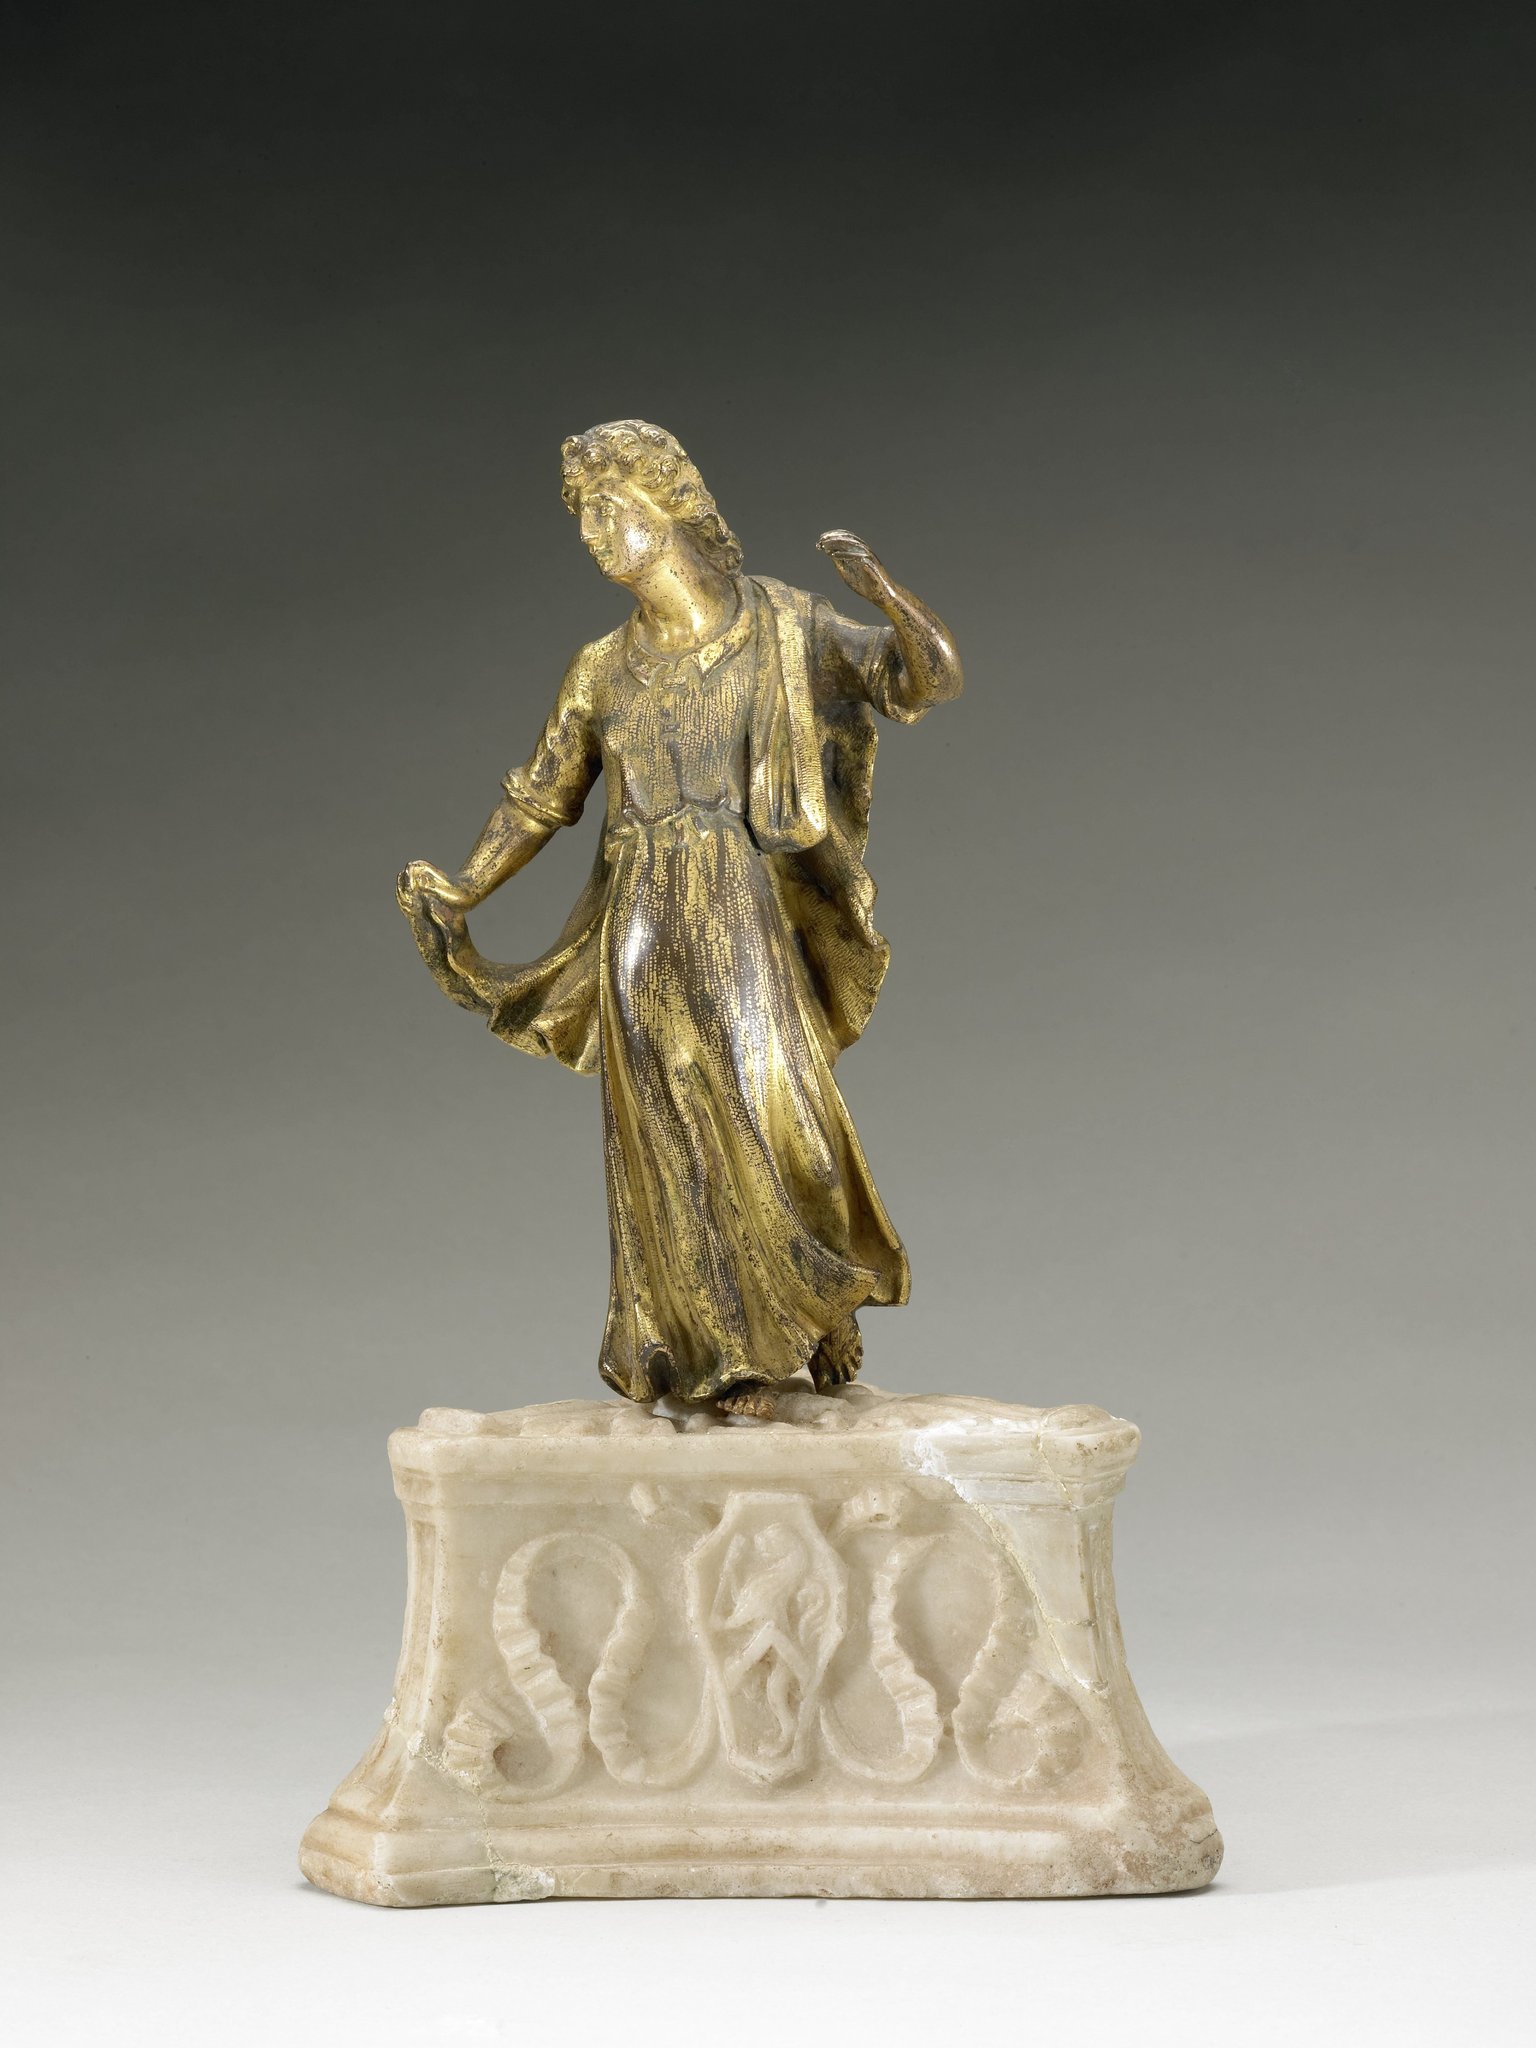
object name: sculpture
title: Genius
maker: Anonymous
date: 1500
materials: bronze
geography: florence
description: Genius Gilt bronze Florence, c. 1500